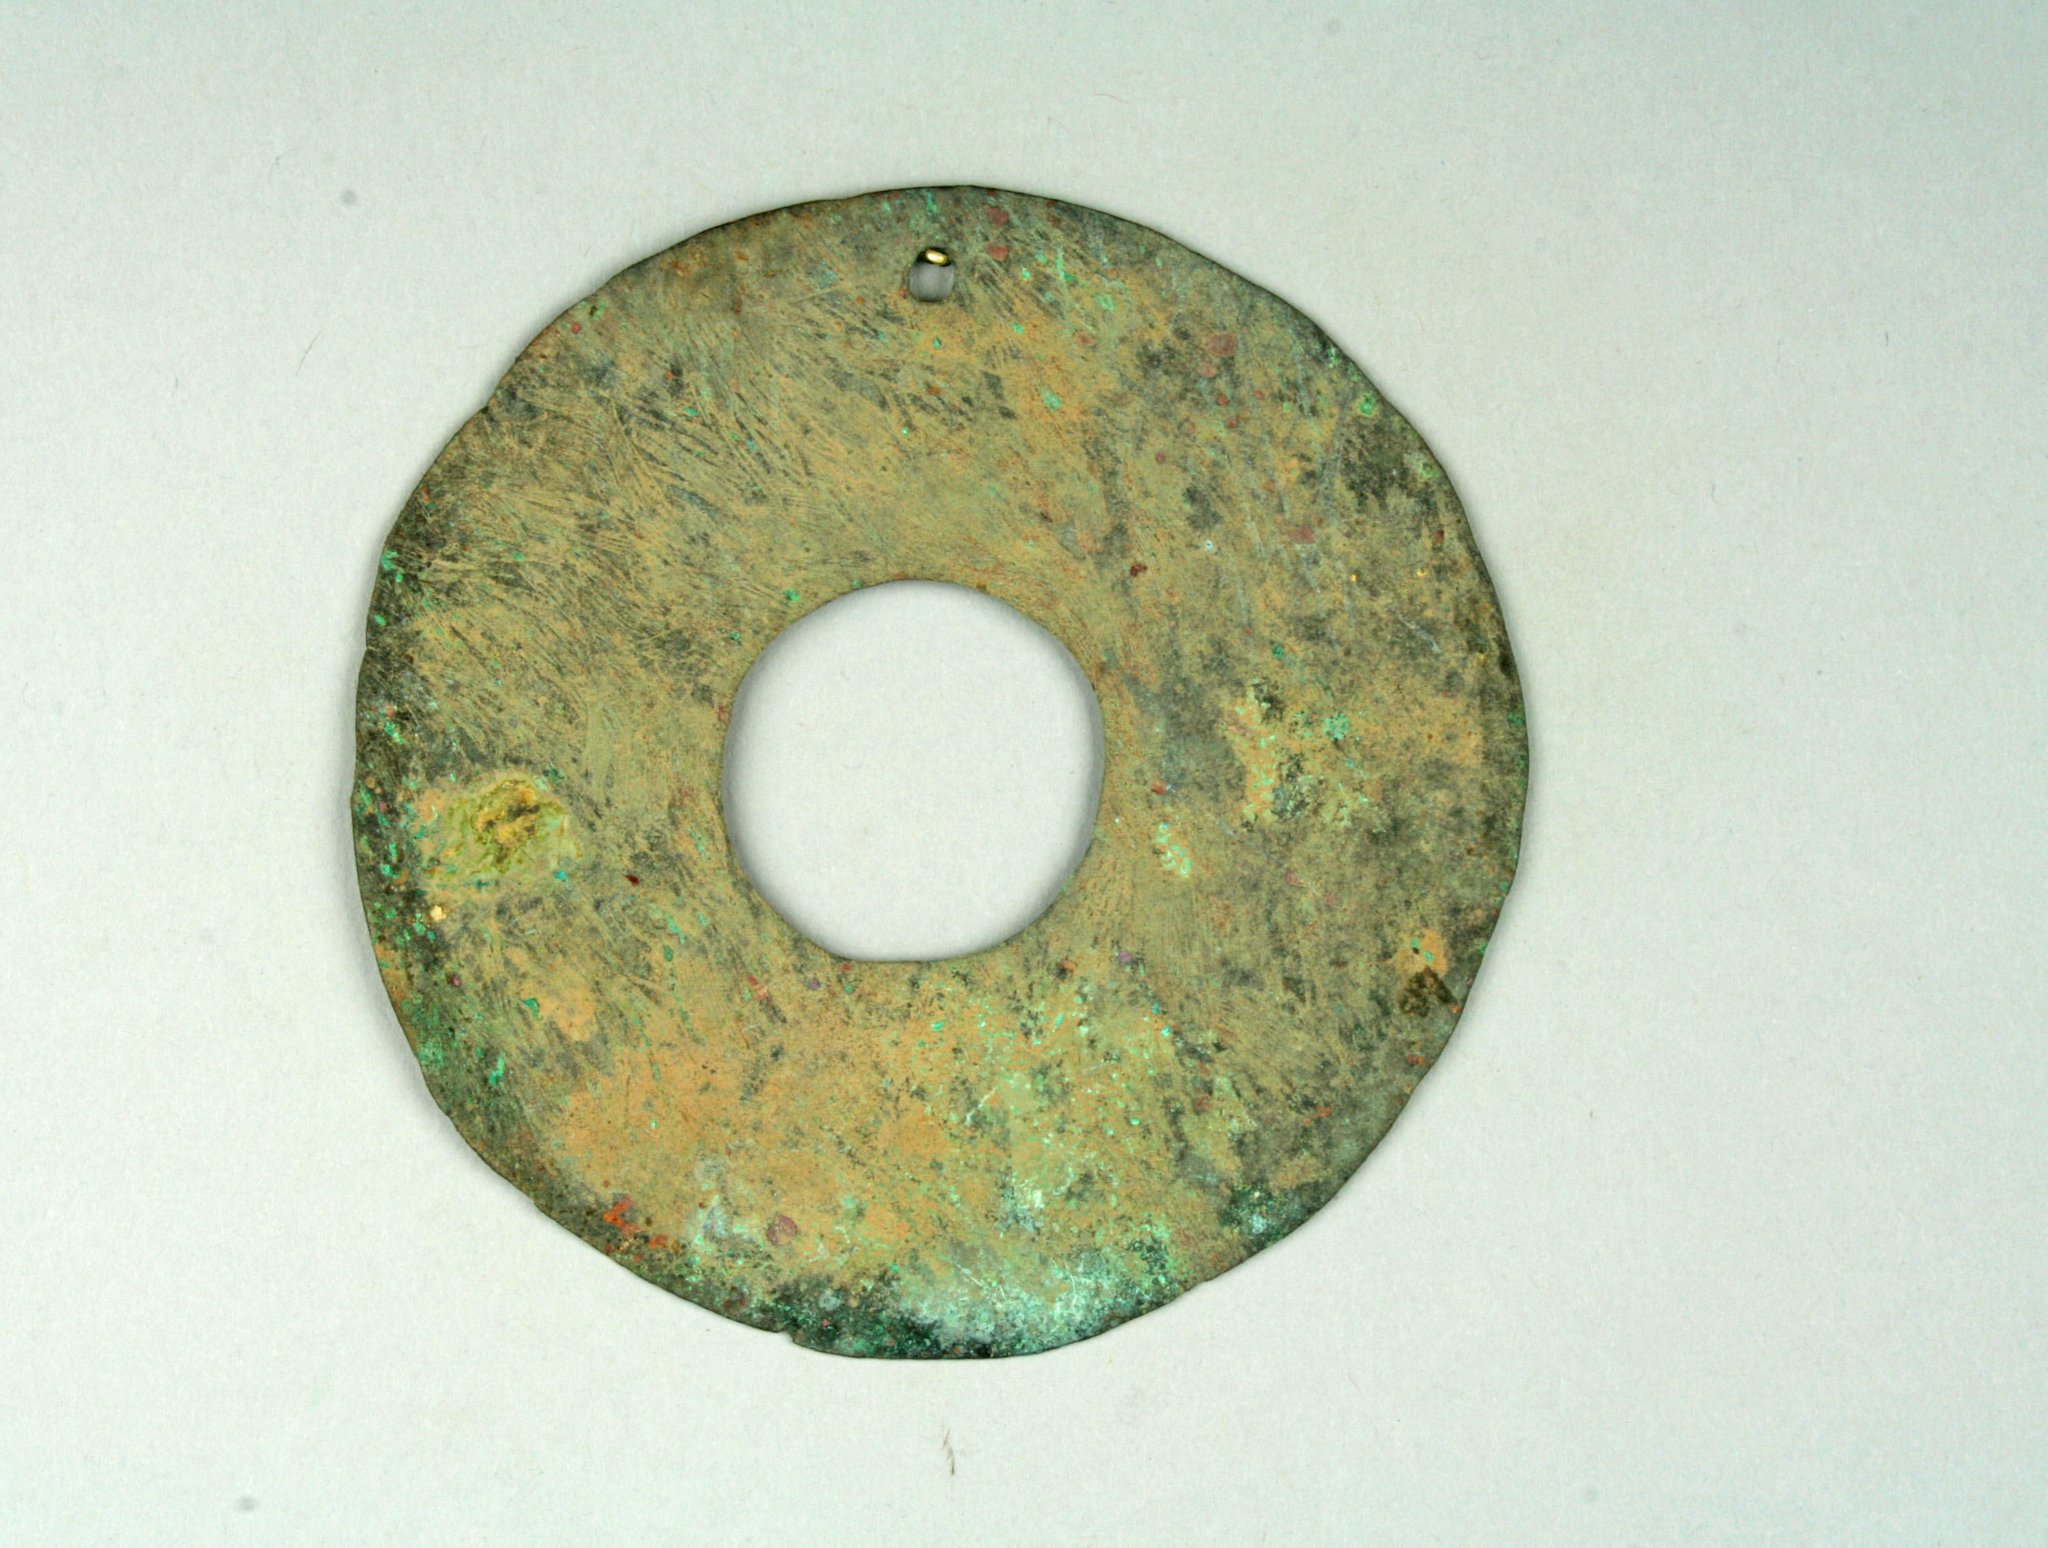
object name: plaque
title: Round Plaque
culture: vicús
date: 300 BCE-200 CE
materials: copper, gilt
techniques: hammering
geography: peru